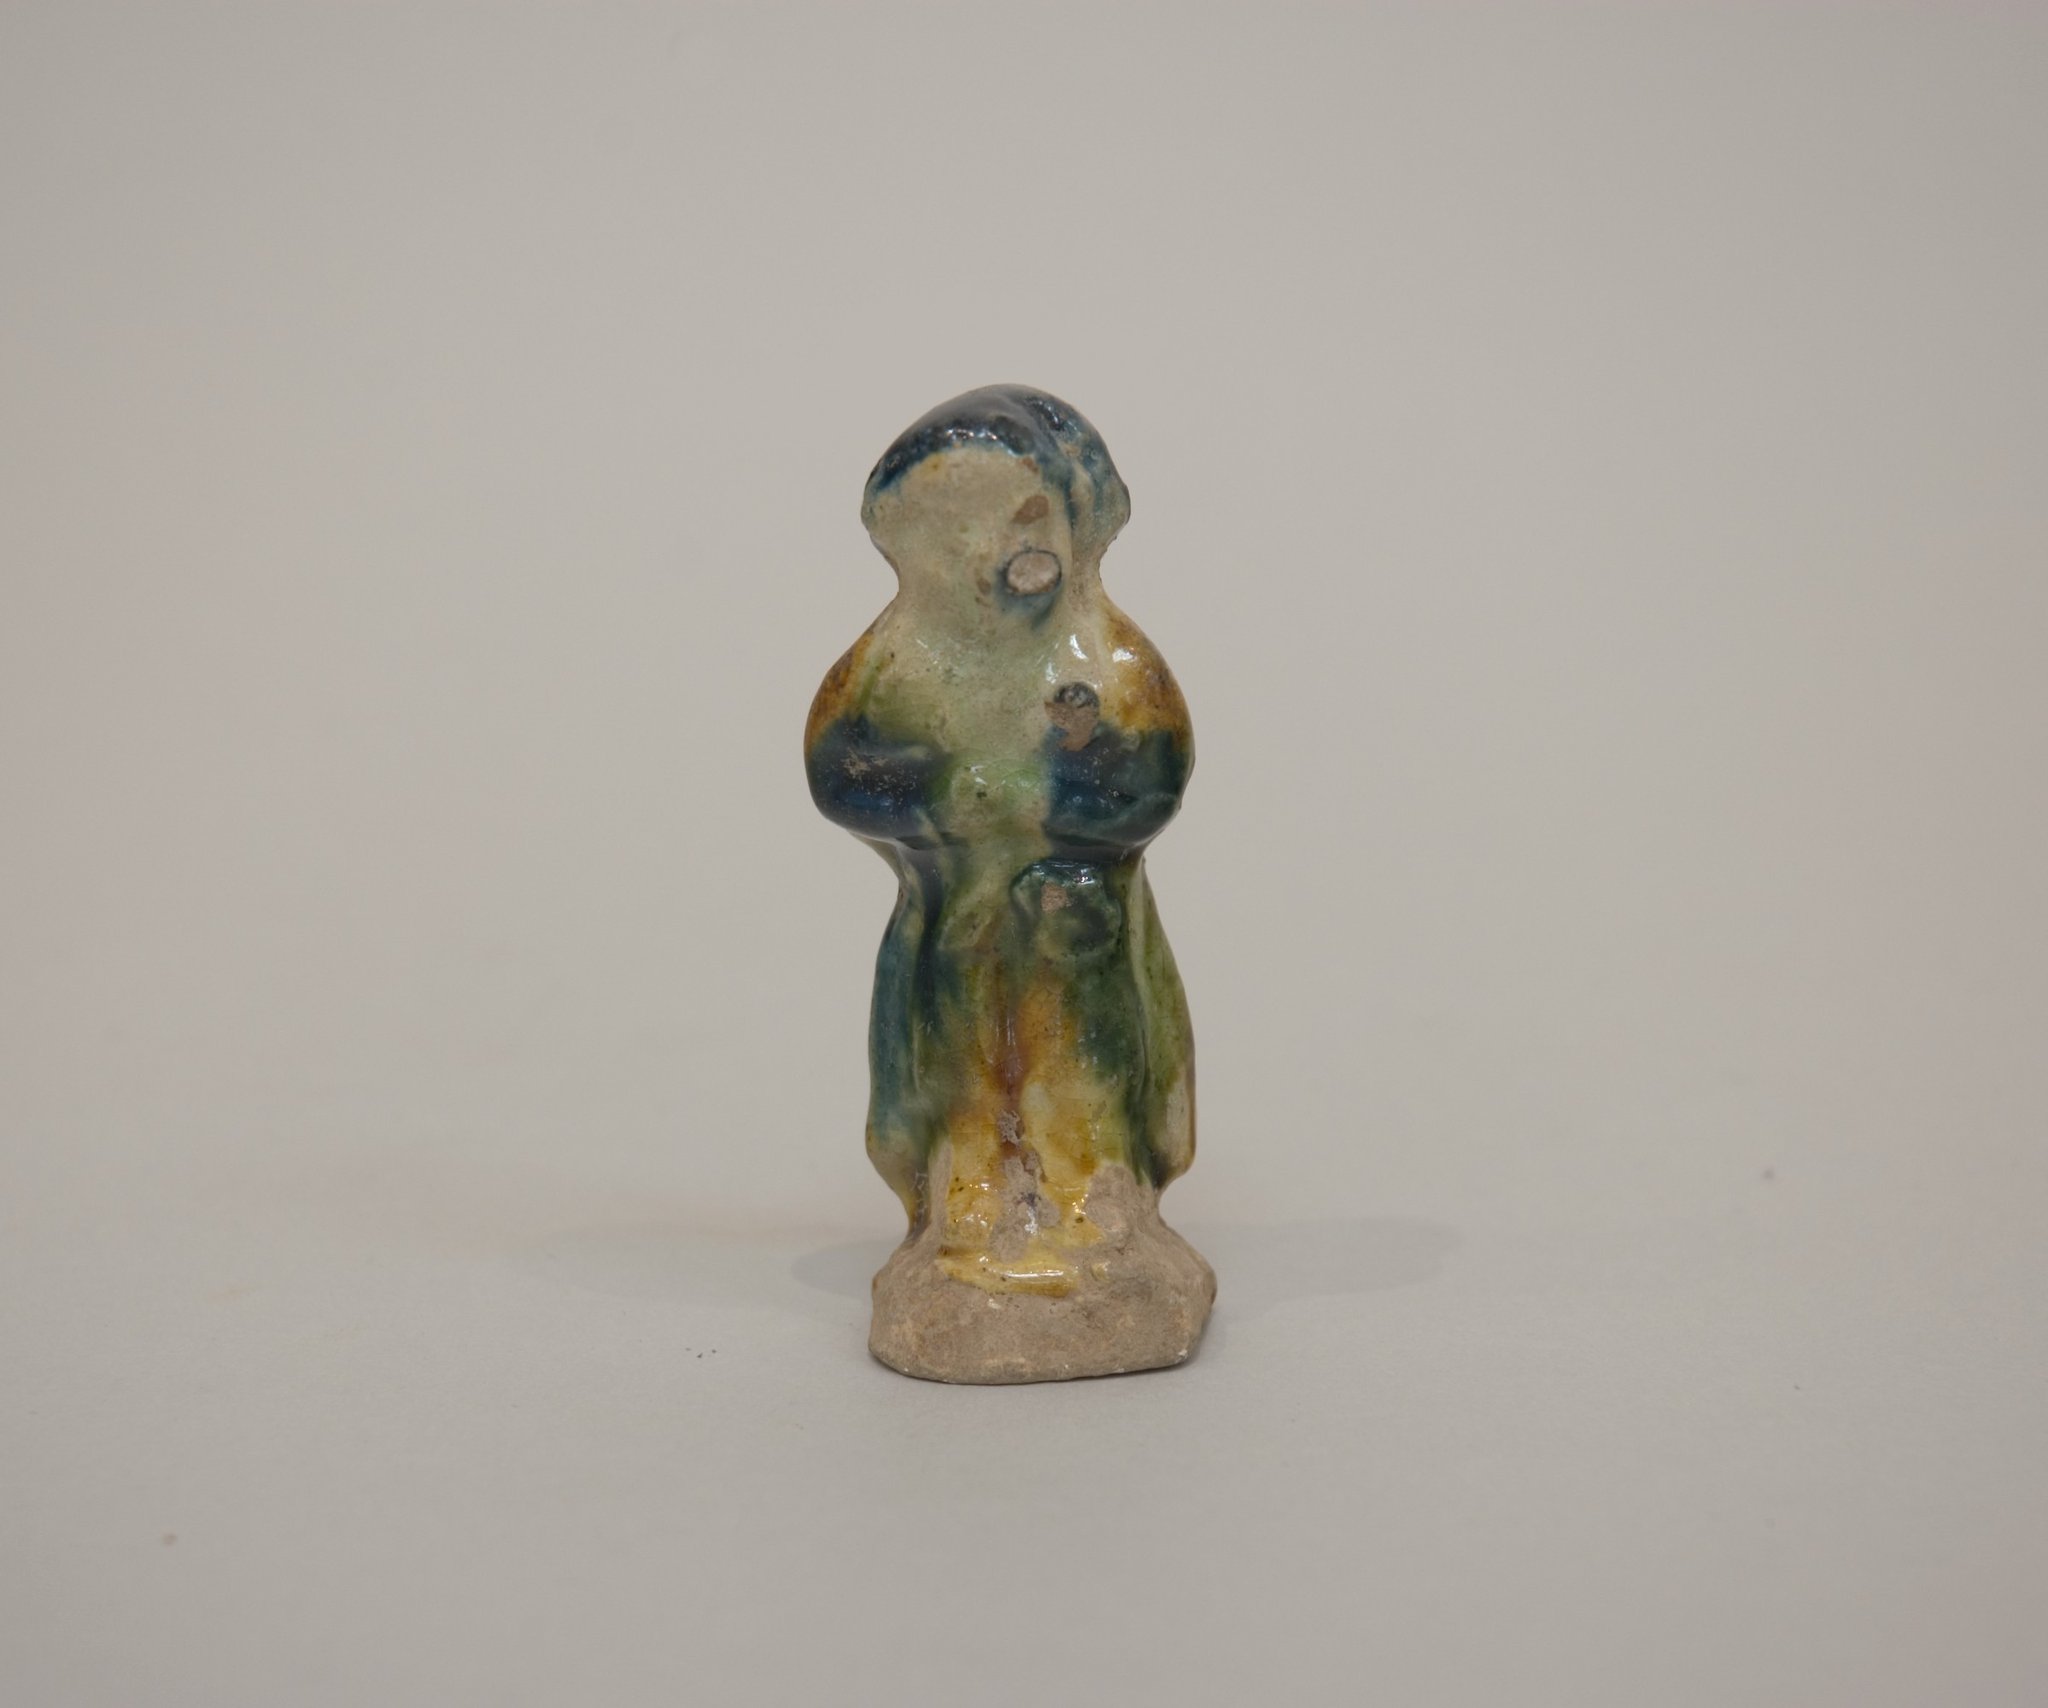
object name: figure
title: Minature standing figure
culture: chinese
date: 701-800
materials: earthenware, glaze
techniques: polychrome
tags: men